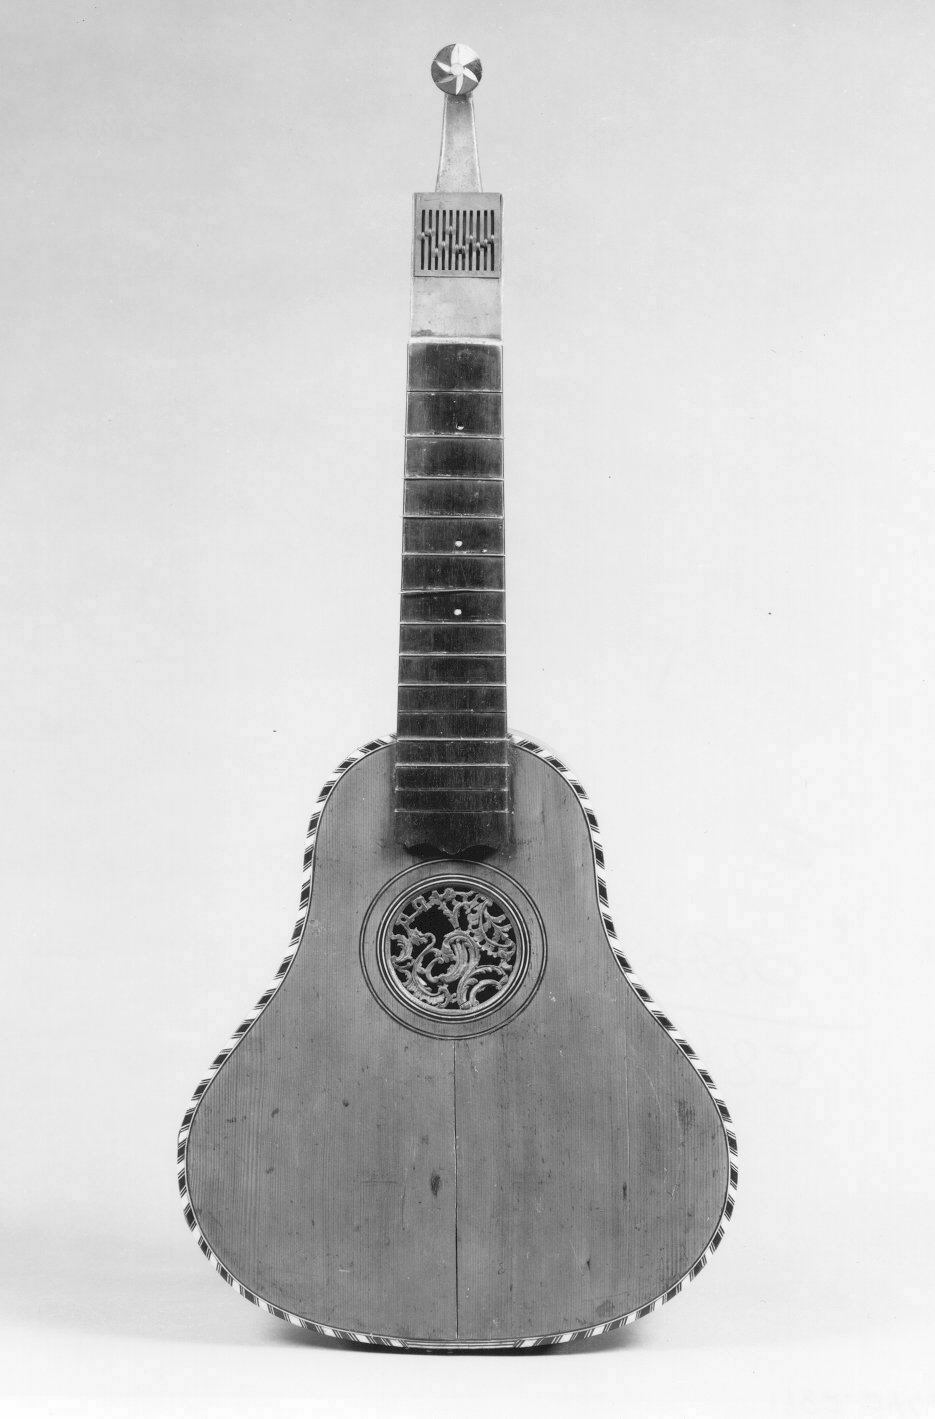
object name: cittern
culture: french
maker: gerard j. deleplanque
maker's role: maker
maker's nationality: french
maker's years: 1754-1790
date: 1772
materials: brass, wood, ivory, mother of pearl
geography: france